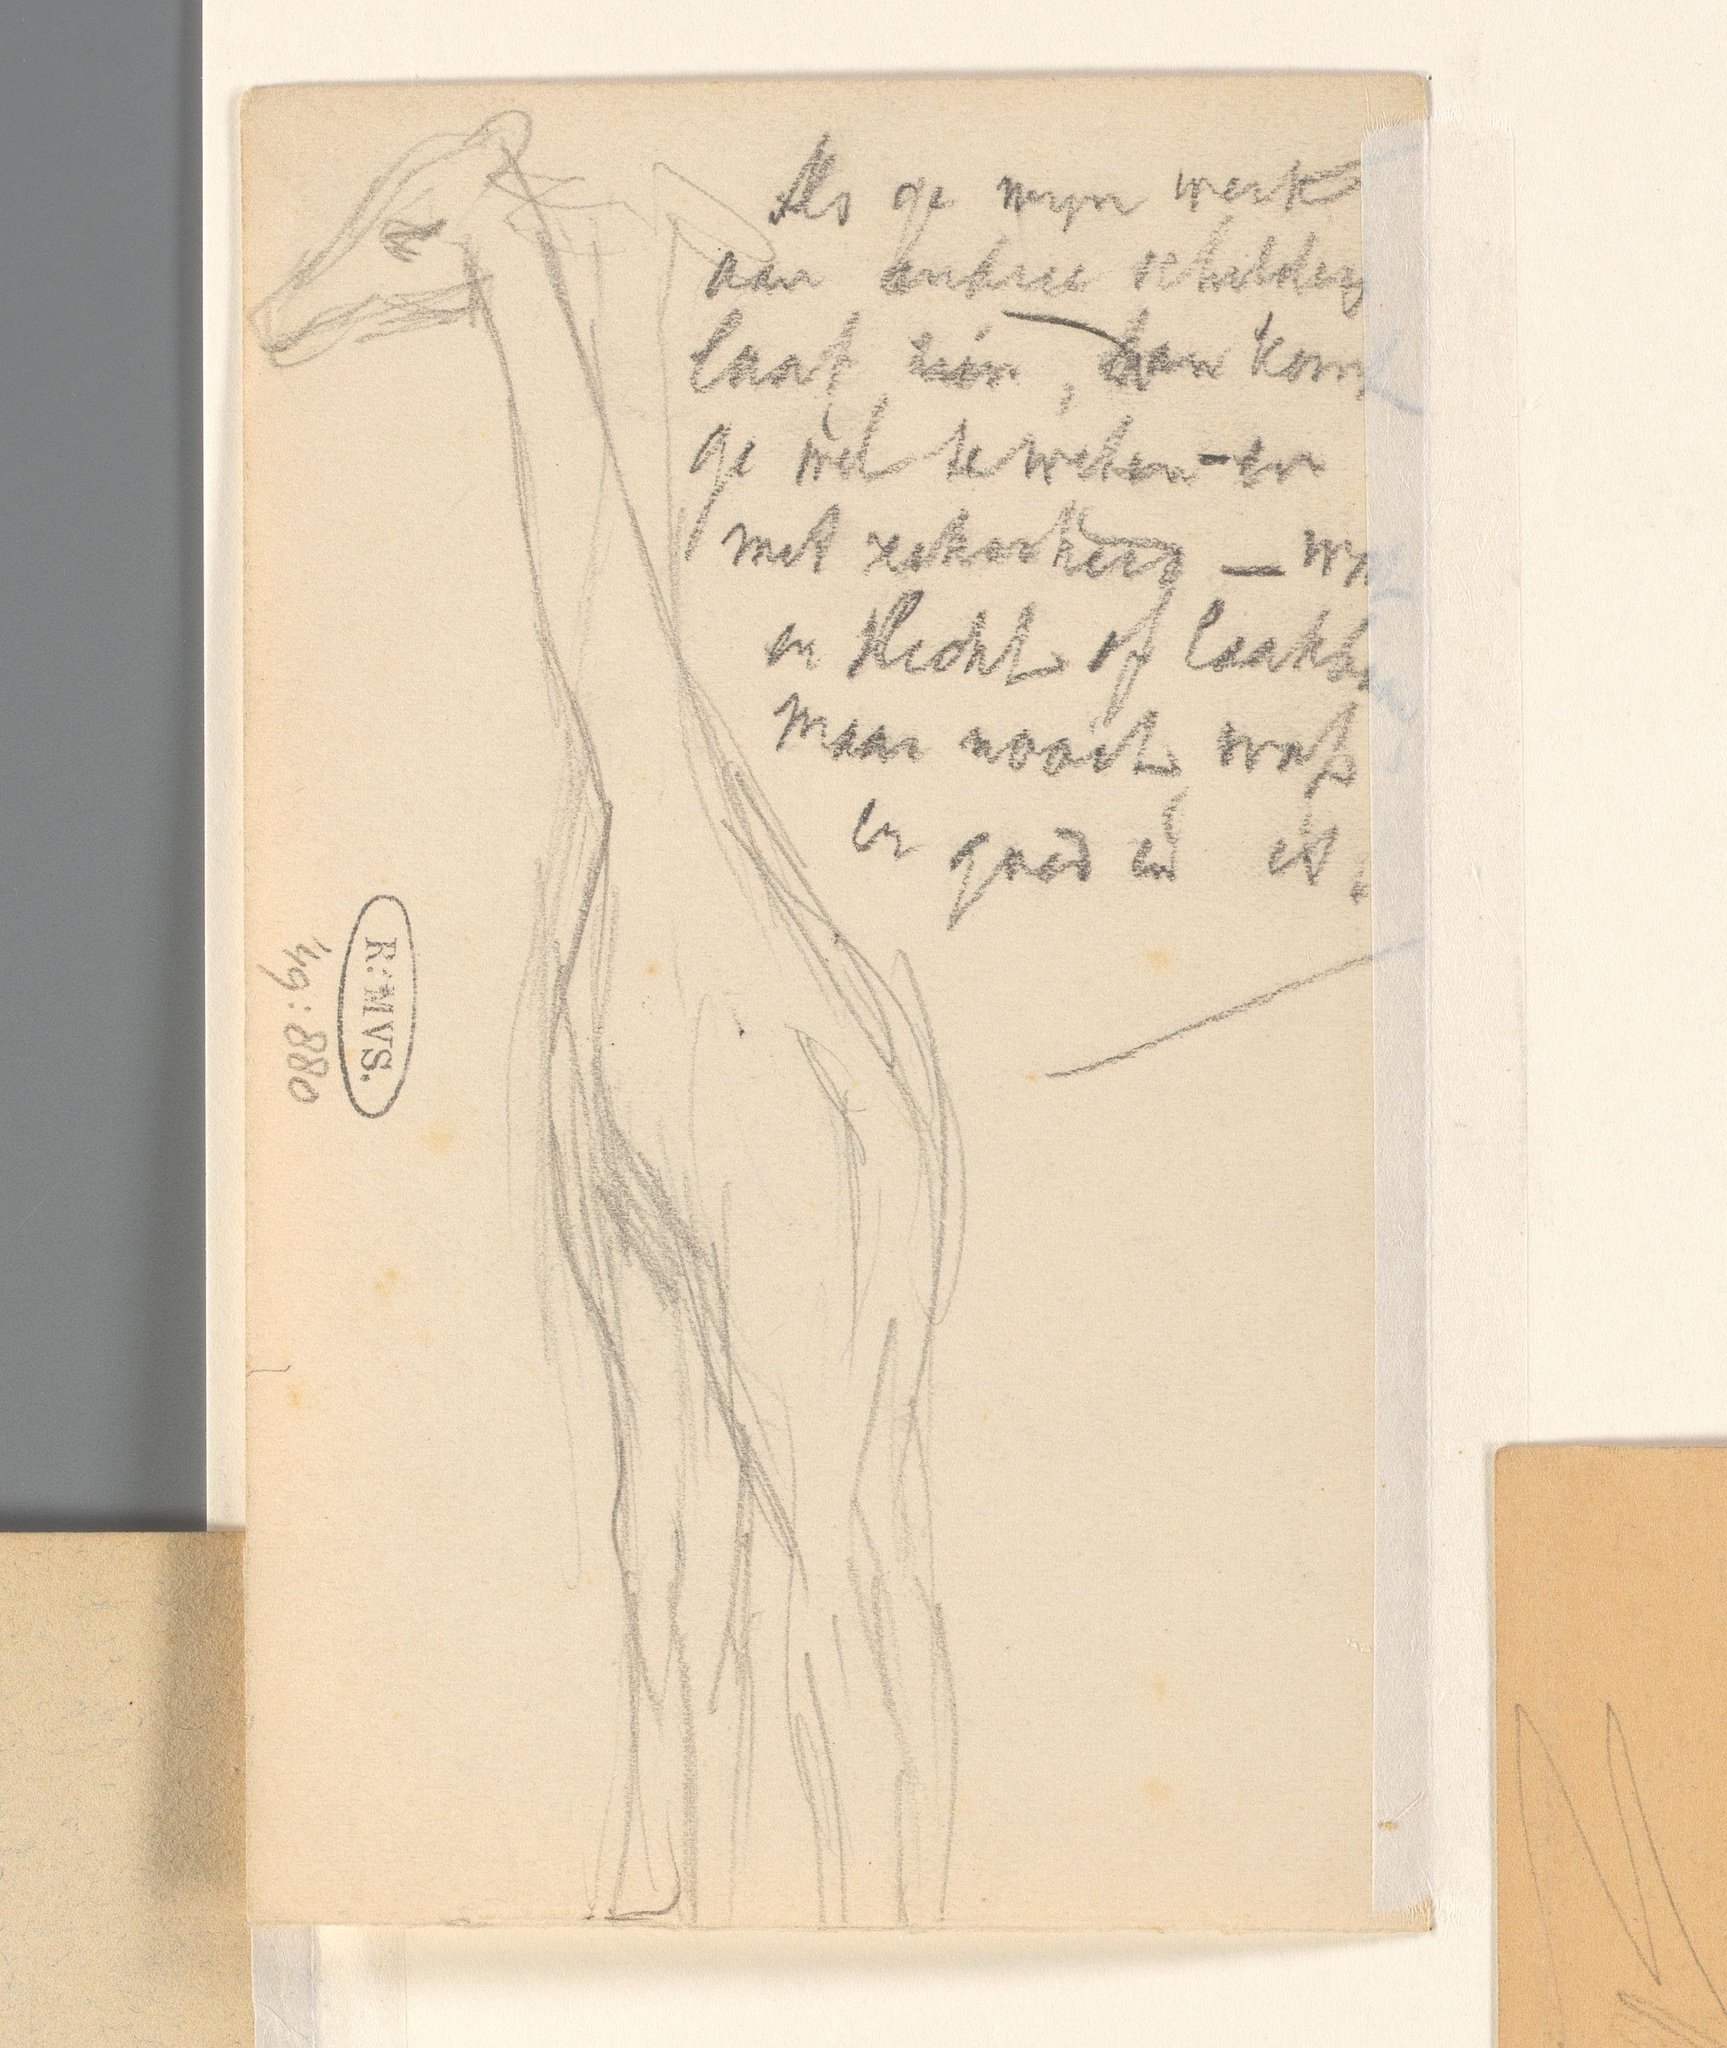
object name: drawing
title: Schetsblad met een giraffe en tekst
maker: august allebé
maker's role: draughtsman, print maker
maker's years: 1838-1927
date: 1848-1927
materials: paper, pencil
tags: hoofed animals: giraffe